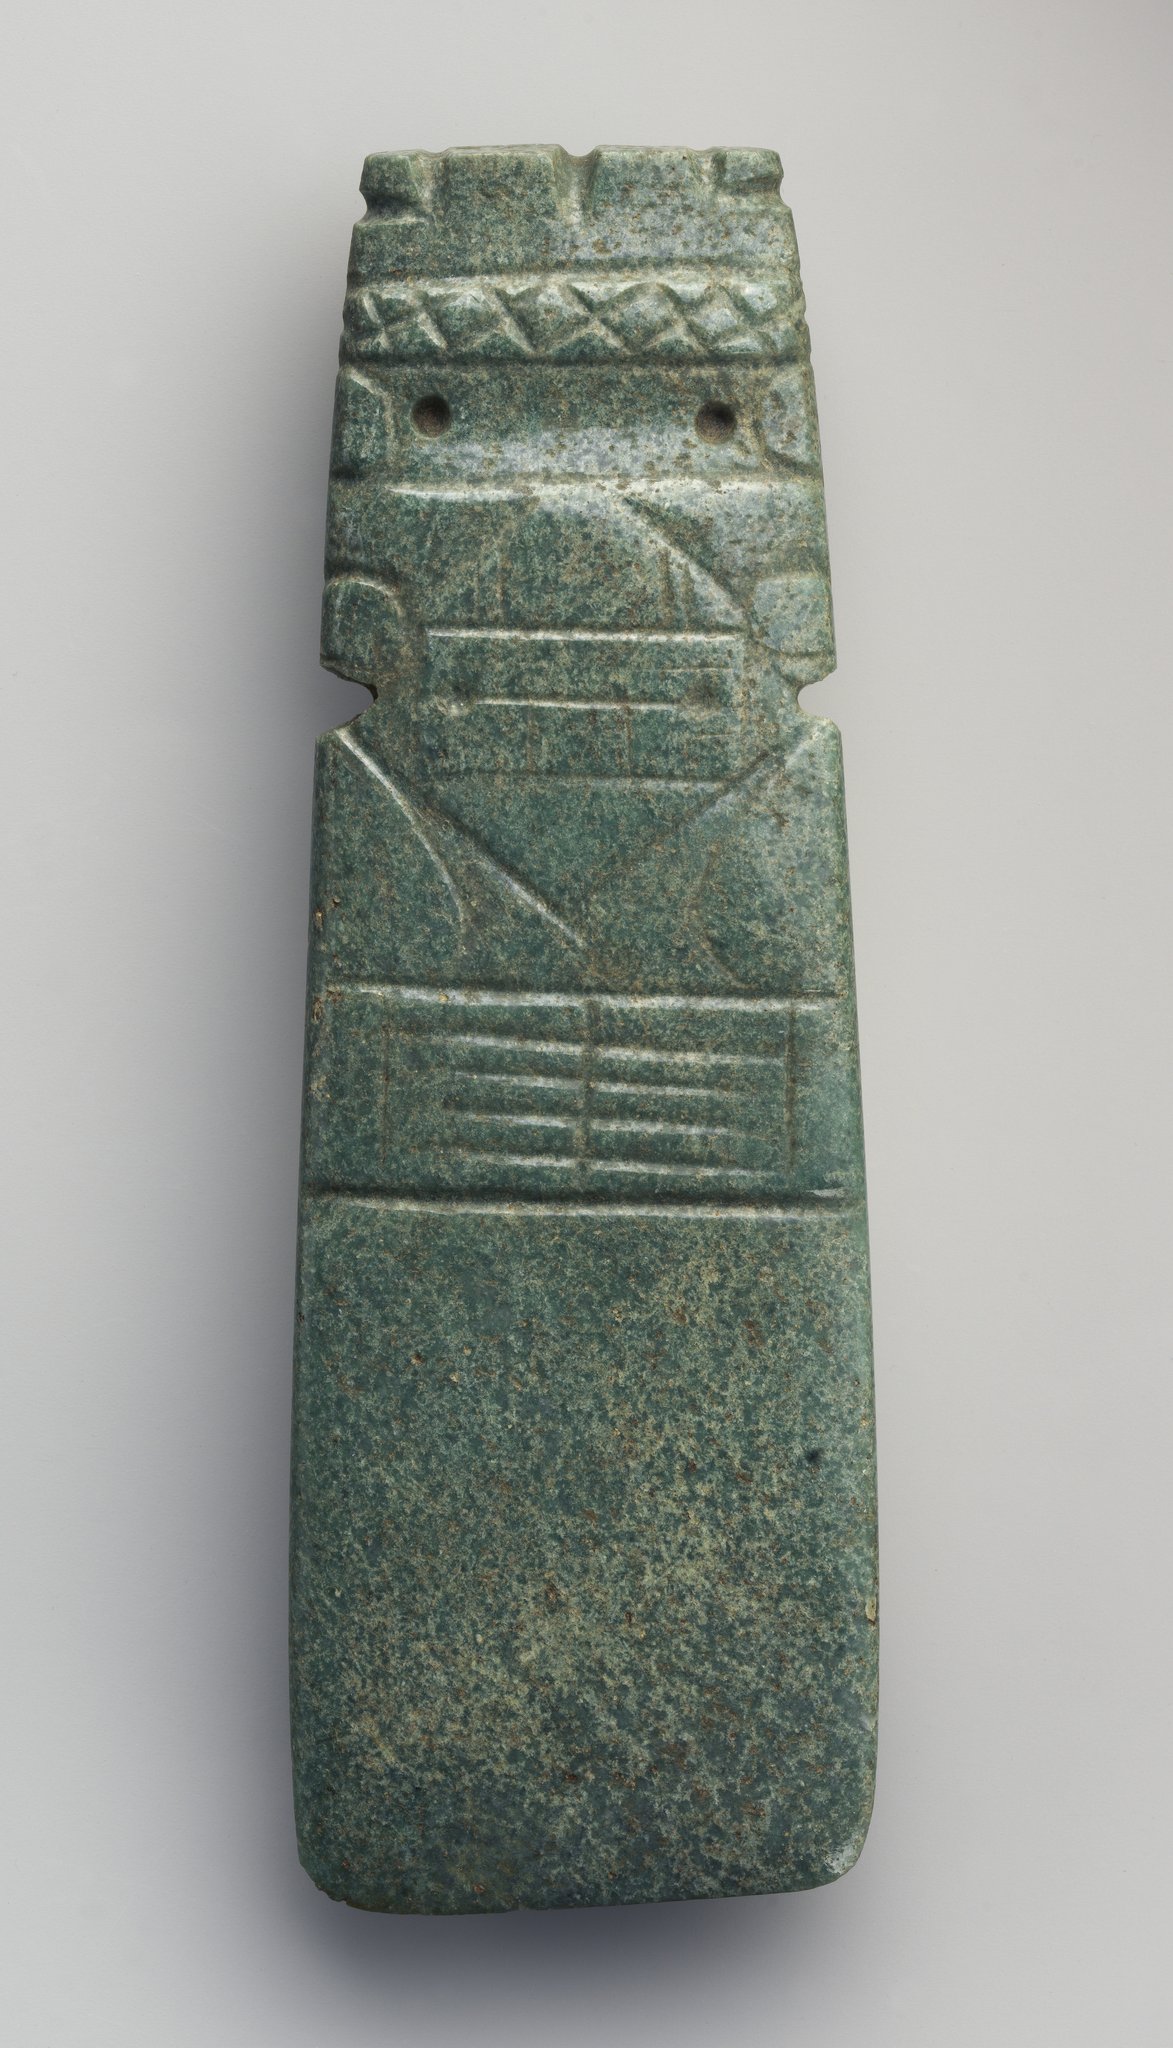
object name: pendant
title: Figure-celt pendant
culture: guanacaste-nicoya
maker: greater nicoya or central region artitst(s)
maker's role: artist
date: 1-700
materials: jade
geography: costa rica